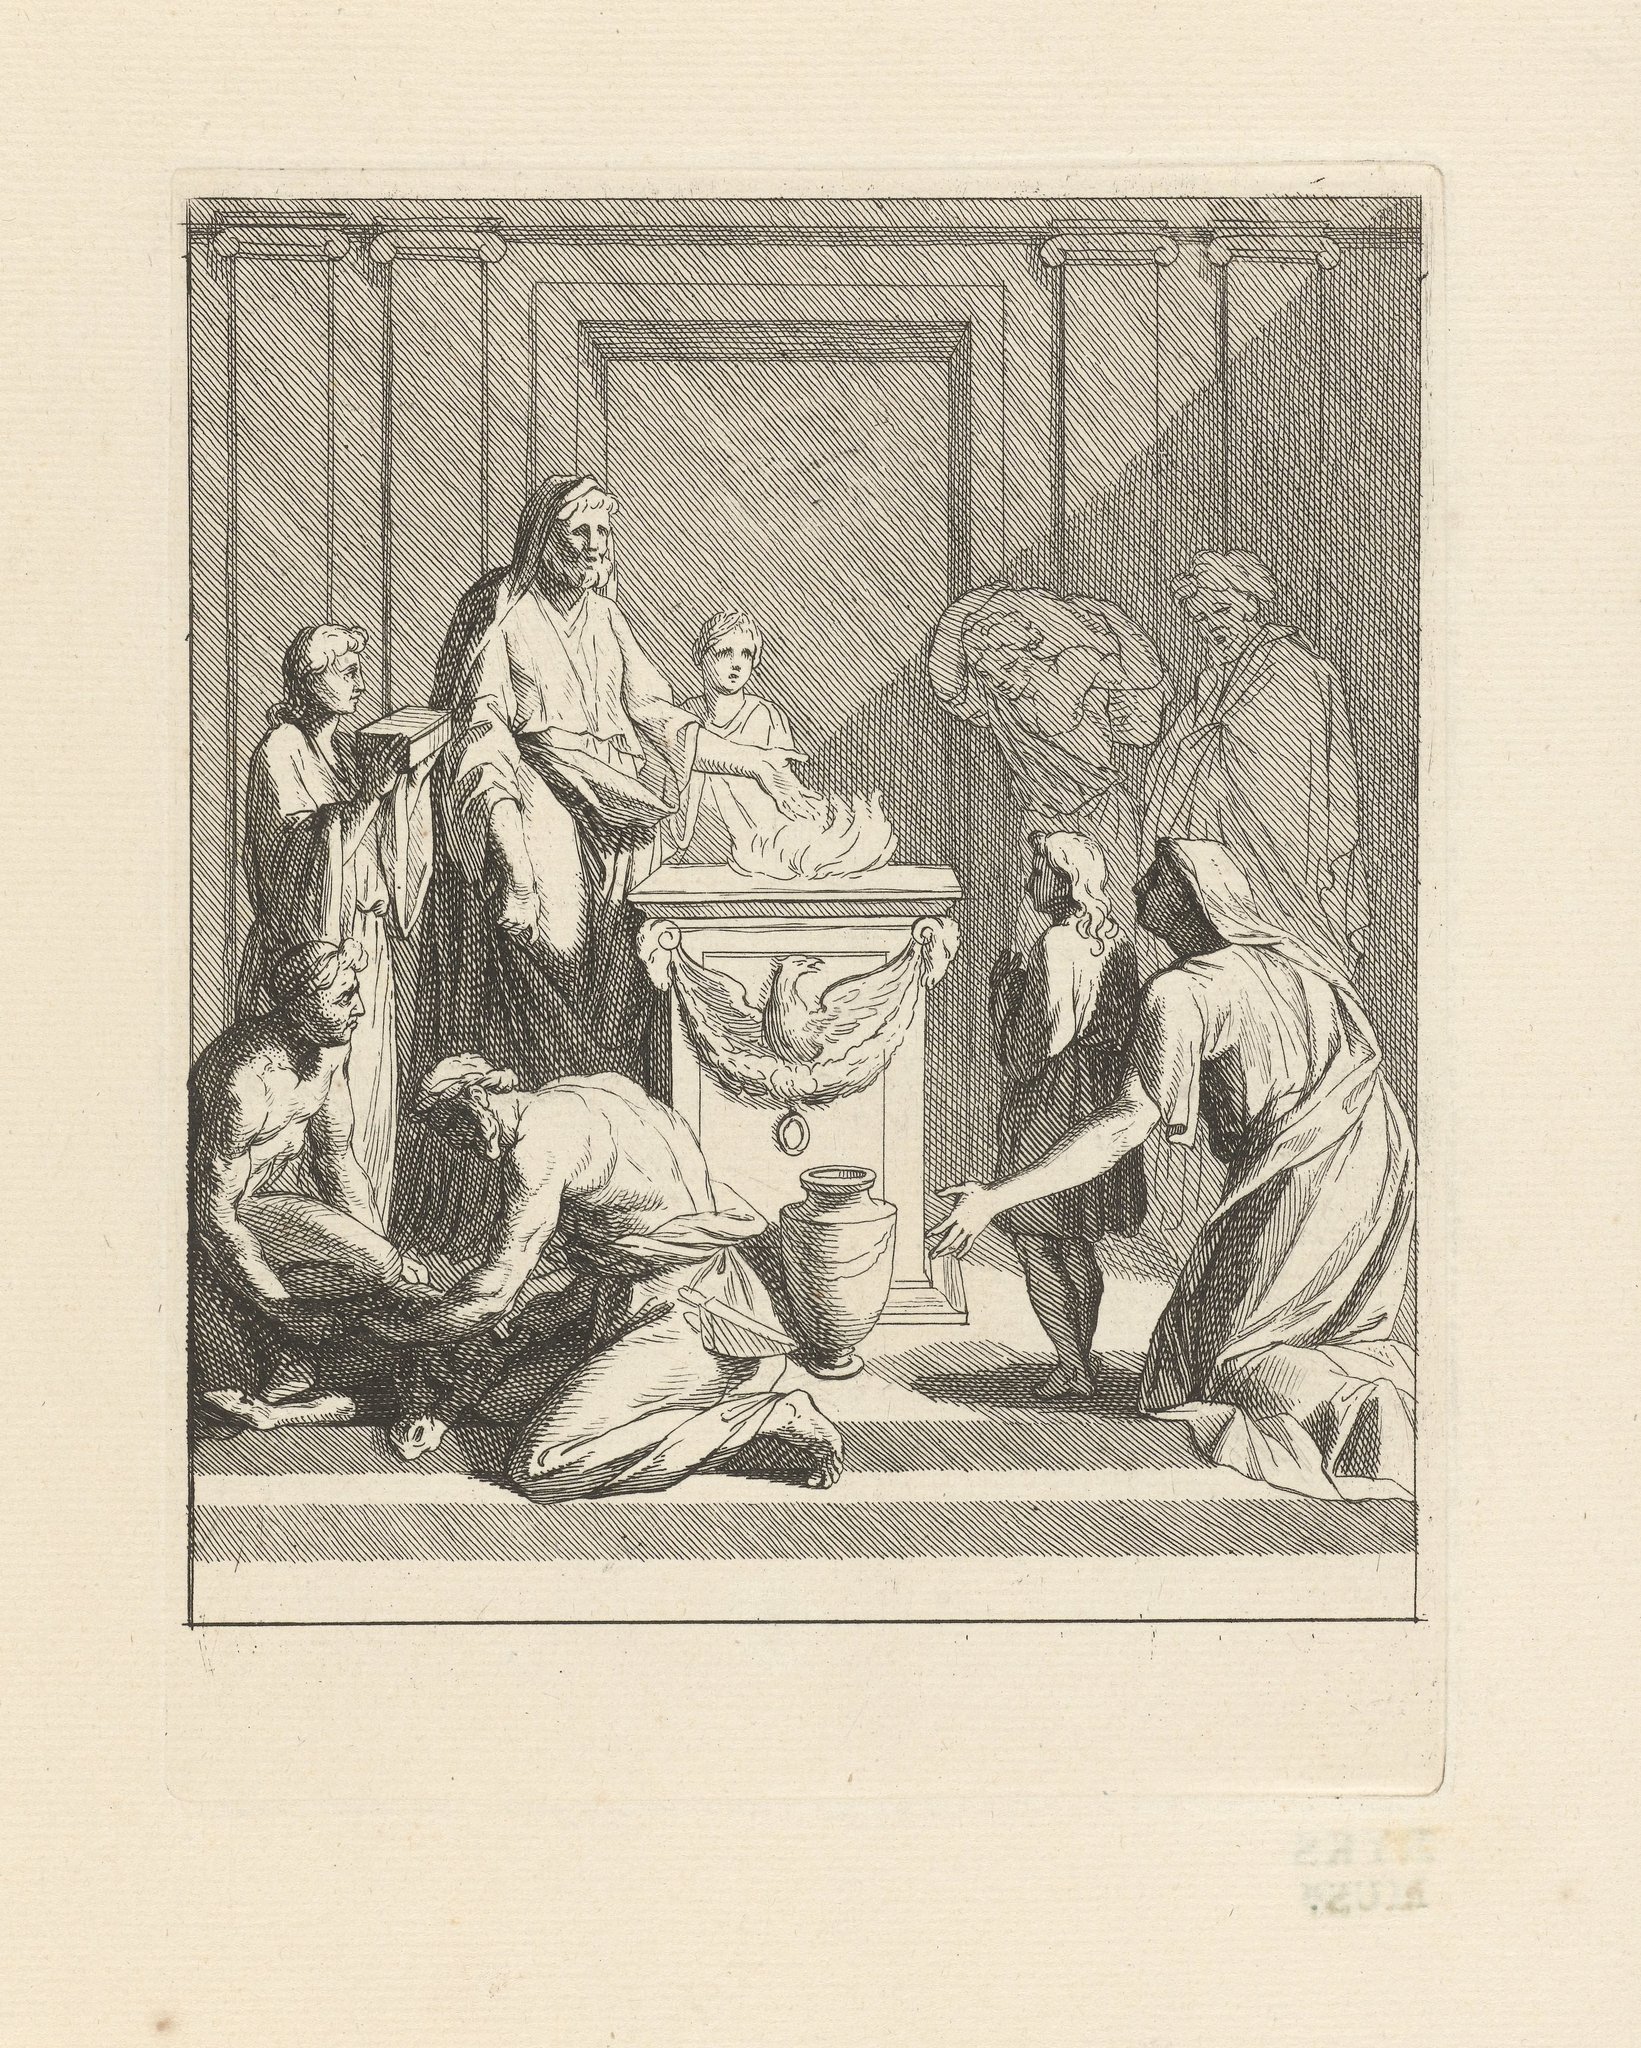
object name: print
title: Een kalf wordt klaargemaakt om geofferd te worden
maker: bernard picart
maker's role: draughtsman, print maker, publisher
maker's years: 1673-1733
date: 1683-1733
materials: paper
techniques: engraving, etching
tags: animal sacrifice ~ roman religion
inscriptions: collector's mark: Lugt 2165